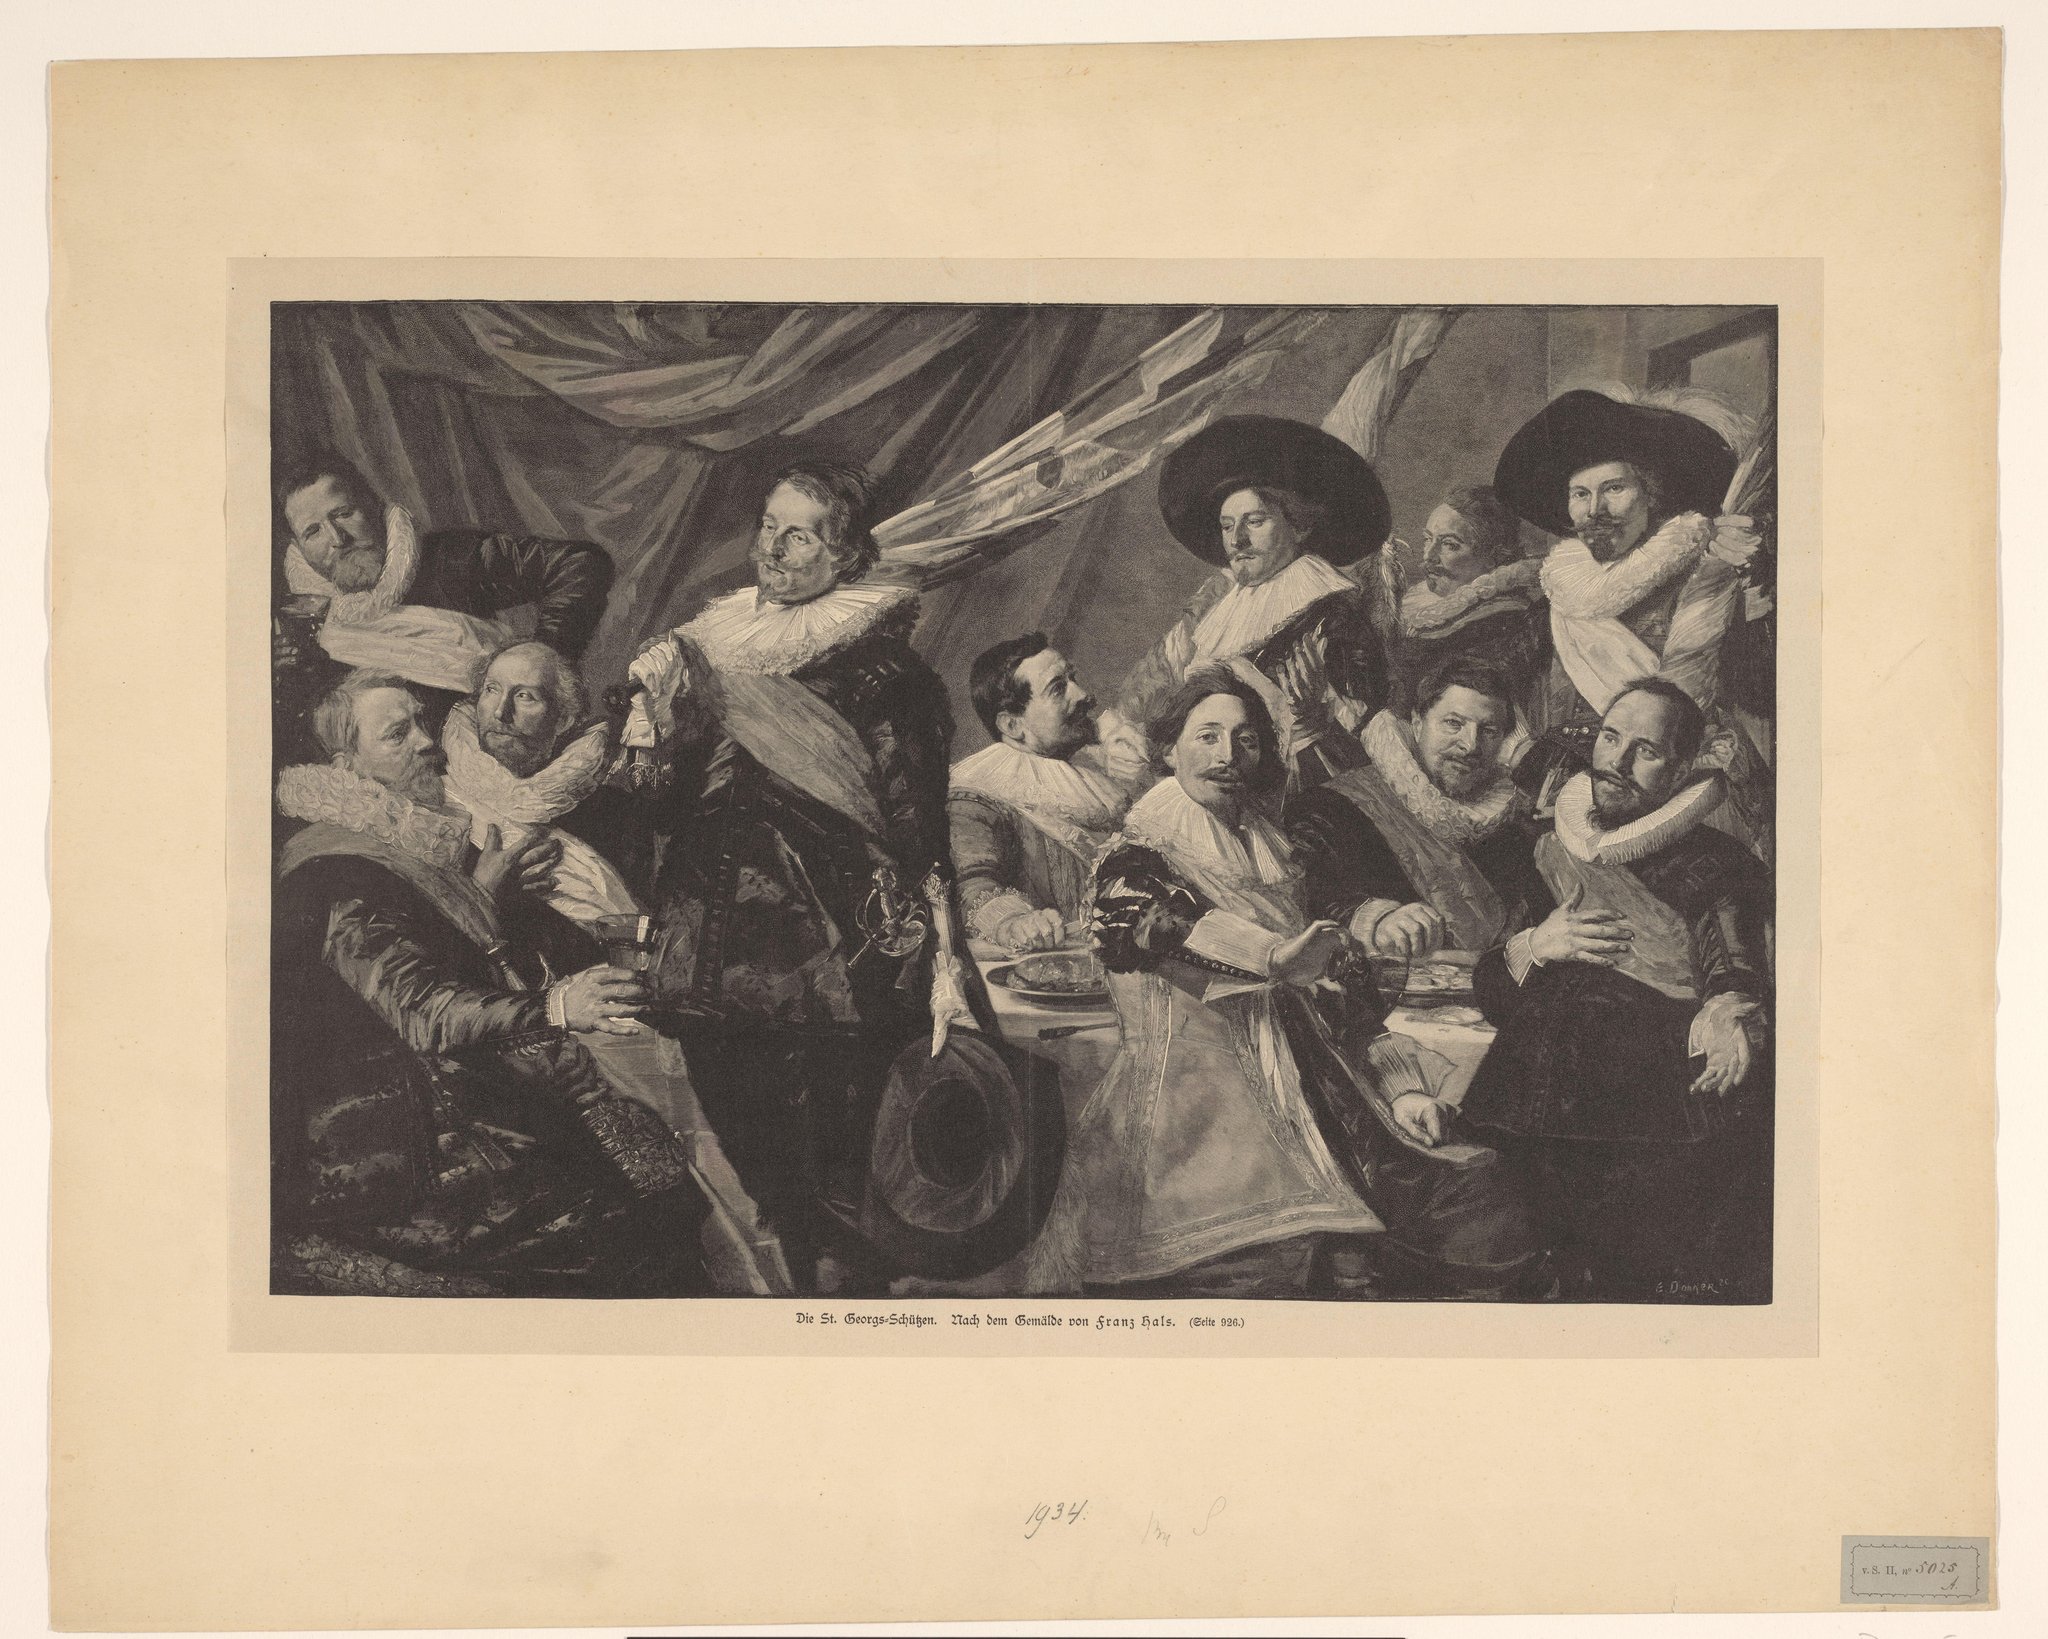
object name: print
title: Feestmaal van de officieren van de St. Jorisschutterij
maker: e. donner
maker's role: print maker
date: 1920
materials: paper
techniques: engraving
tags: warfare; military affairs (+ citizen soldiery, civil guard, citizen militia), celebration meal, feast, banquet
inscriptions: collector's mark: Lugt 2228